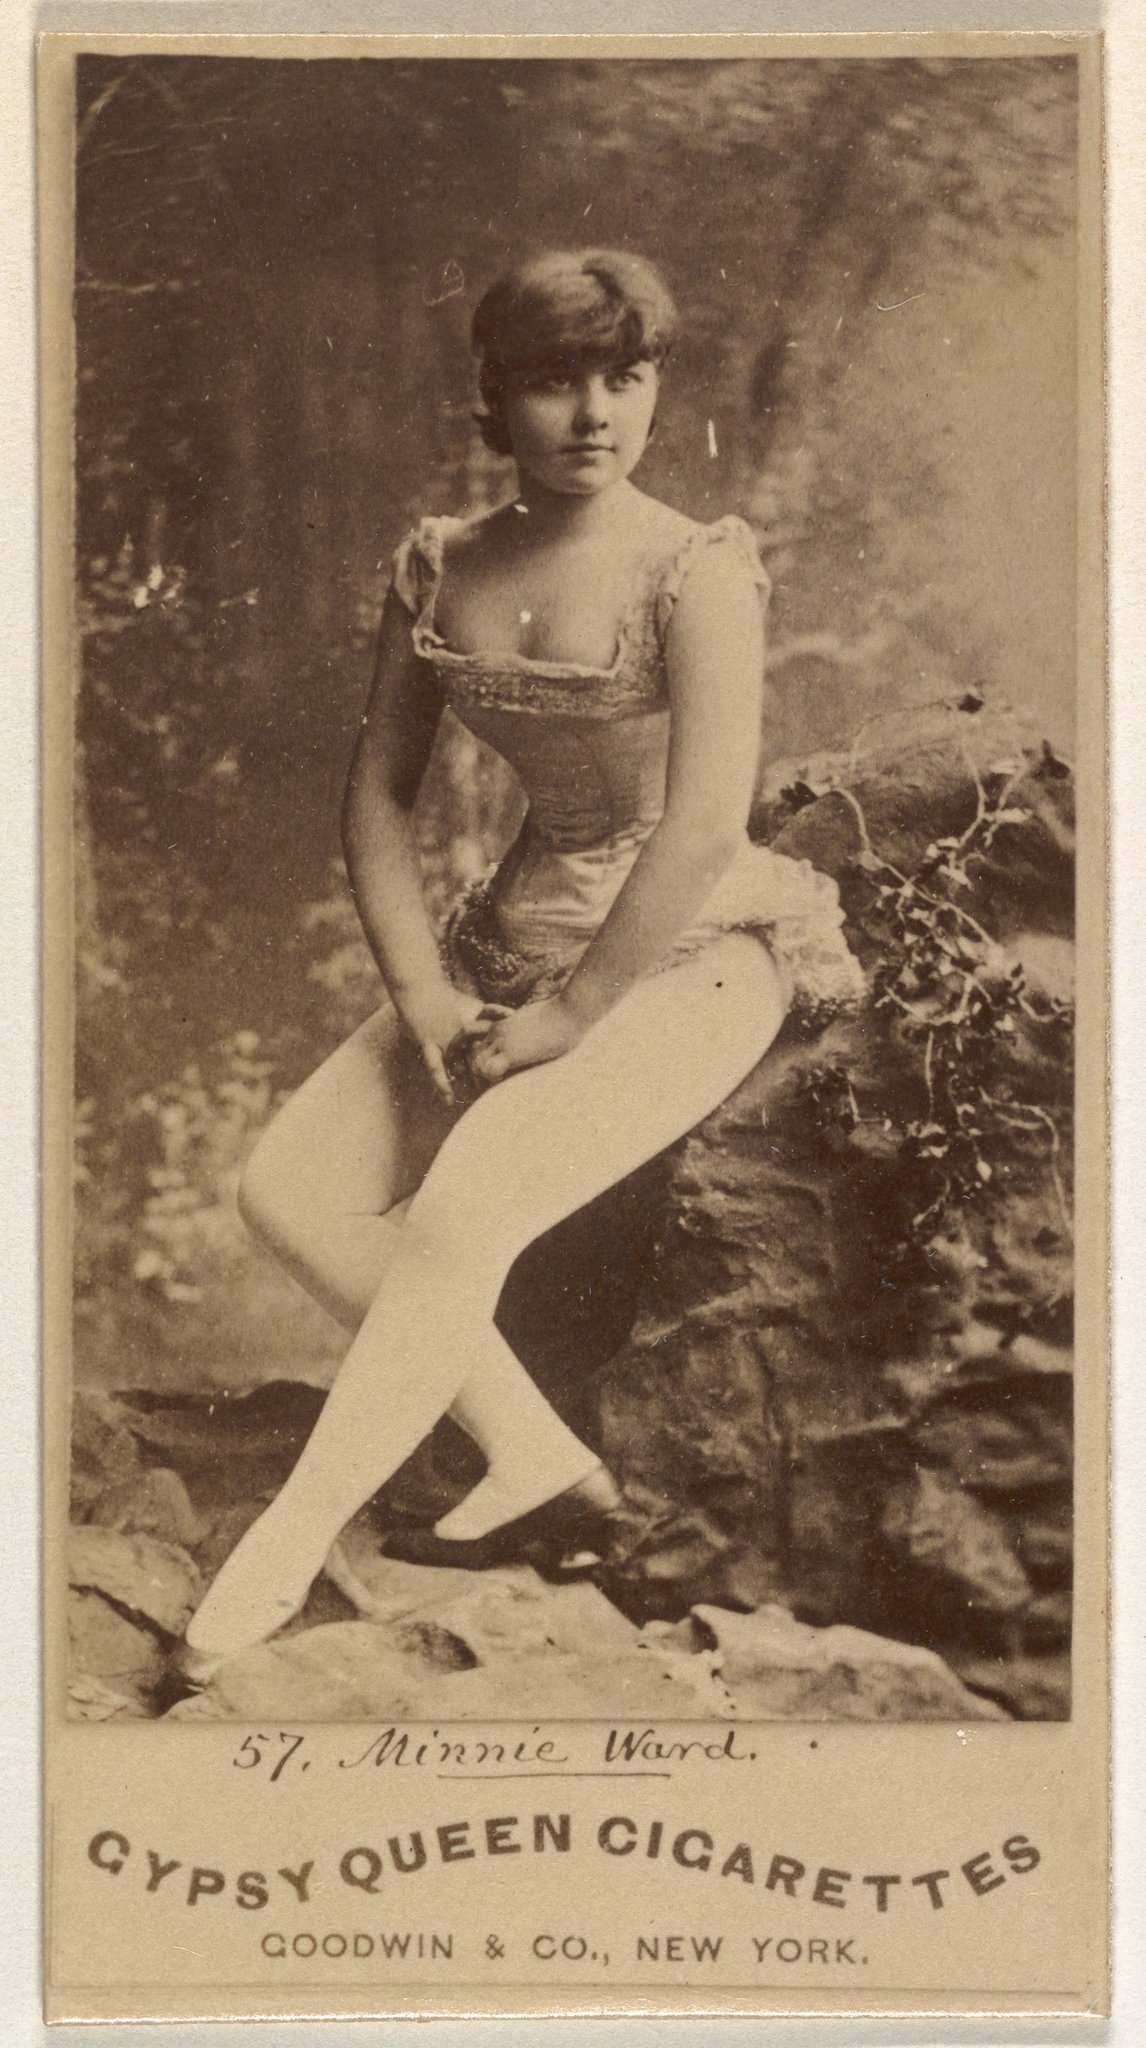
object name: photograph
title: Minnie Ward, from the Actors and Actresses series (N171) for Gypsy Queen Cigarettes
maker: goodwin & company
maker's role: publisher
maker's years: 1850-1950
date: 1886-1890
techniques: albumen silver print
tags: portraits,women,actresses